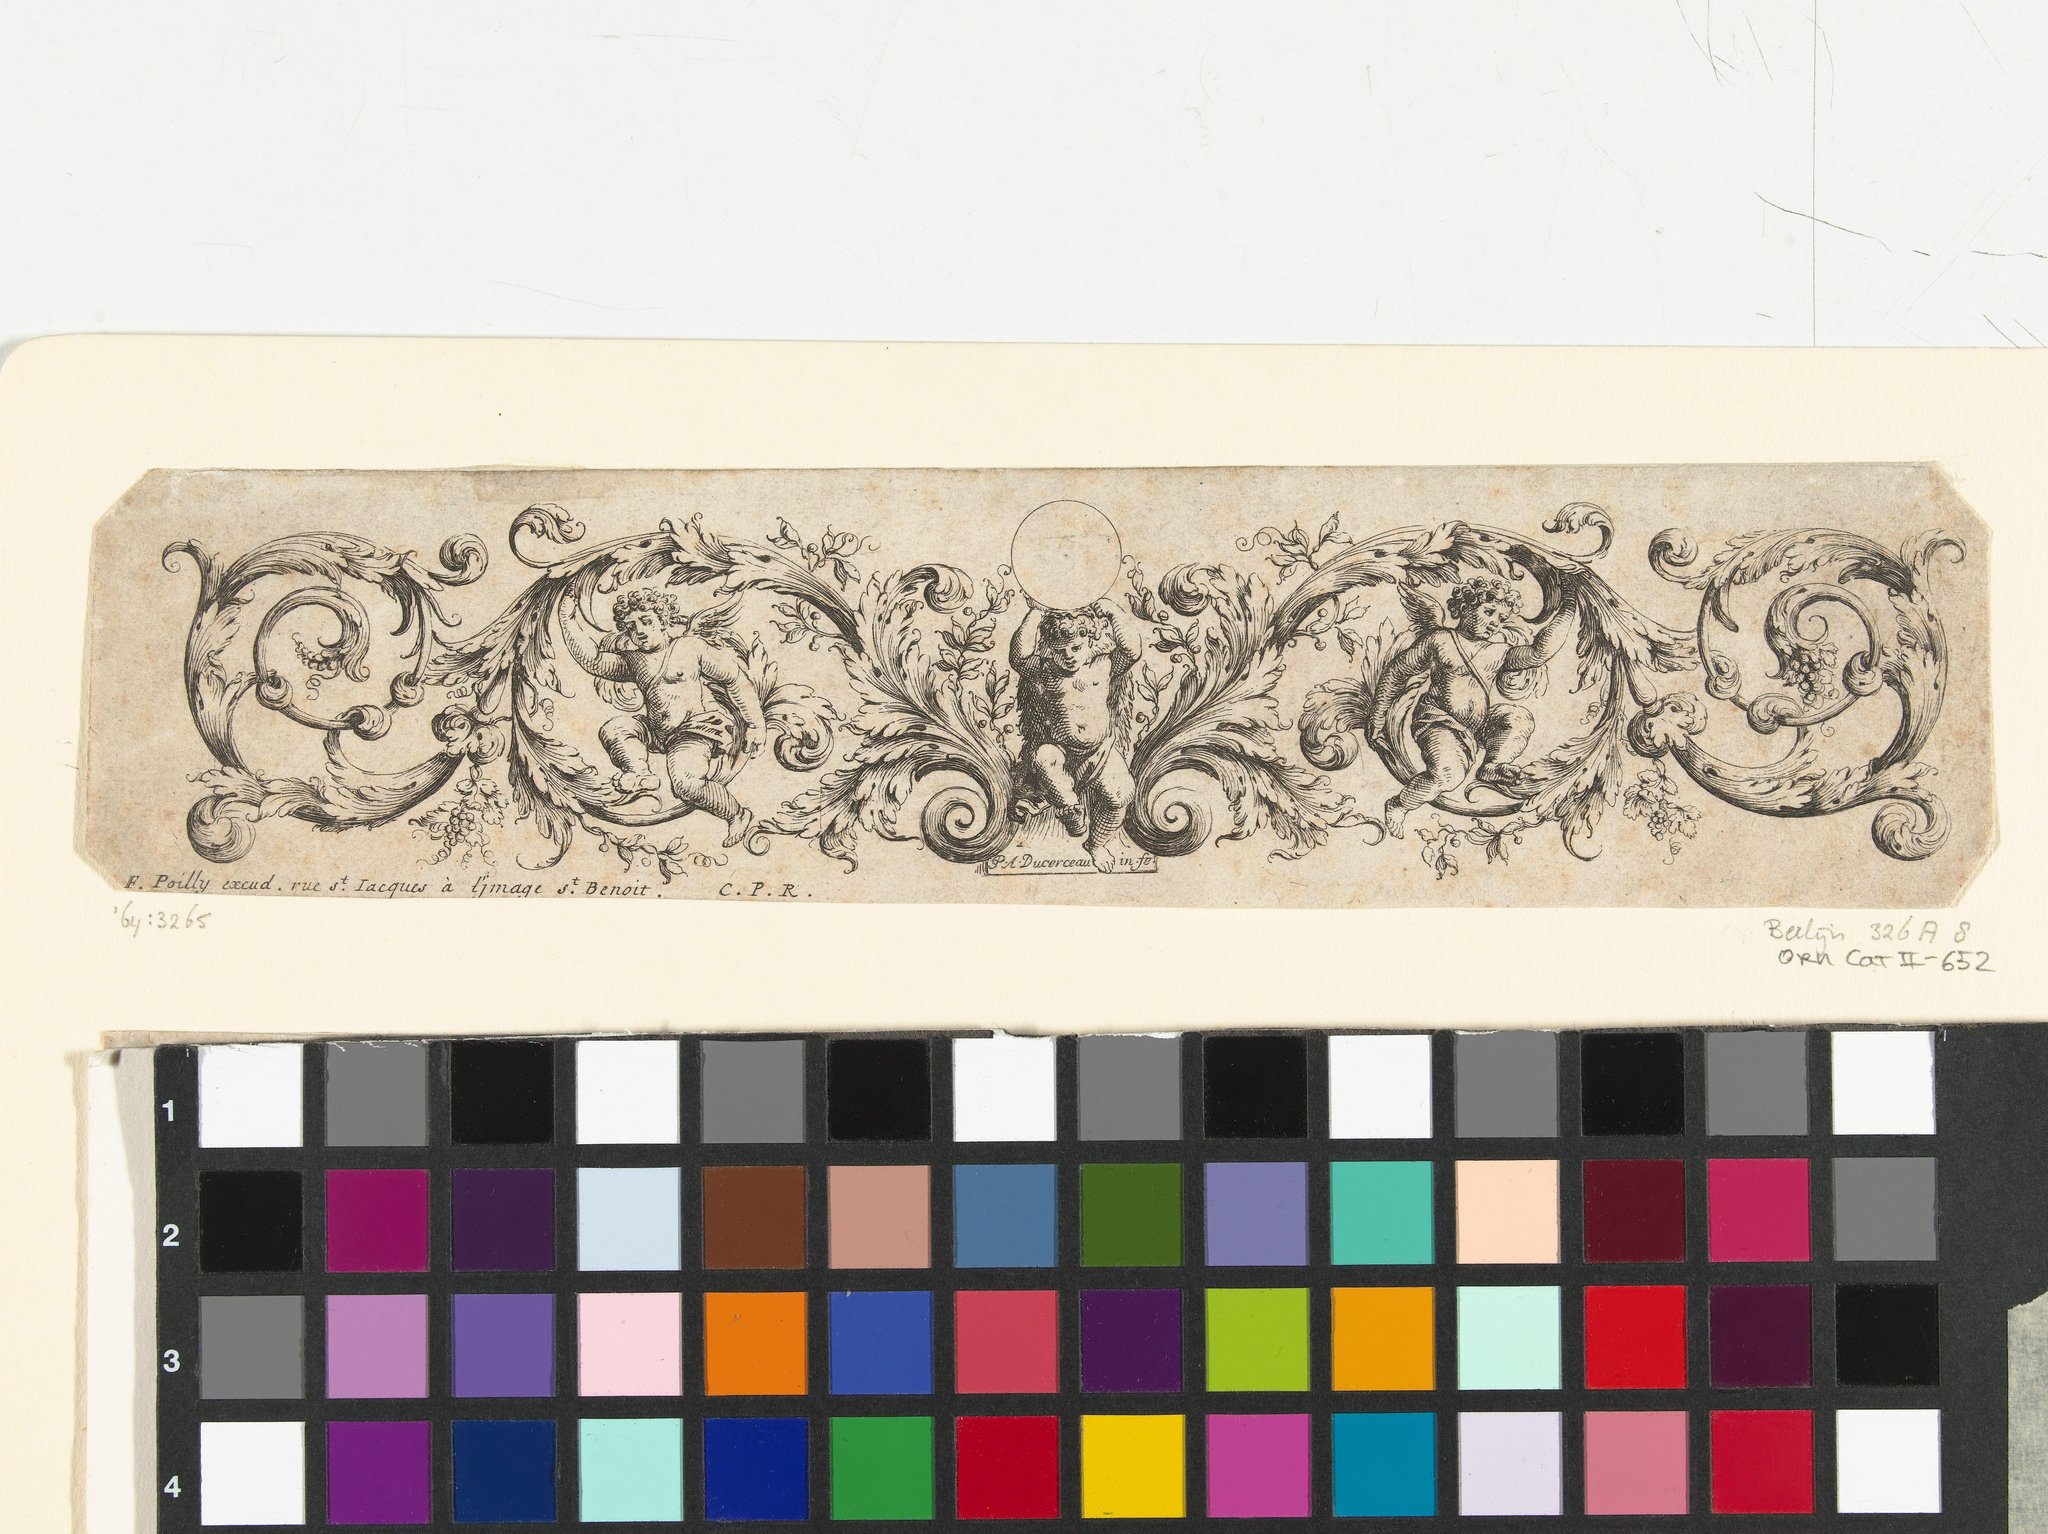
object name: ornament print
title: Twee bladranken met amoretten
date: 1670-1693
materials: paper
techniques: etching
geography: france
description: De amoretto in het midden houdt een lege cirkel boven zijn hoofd.